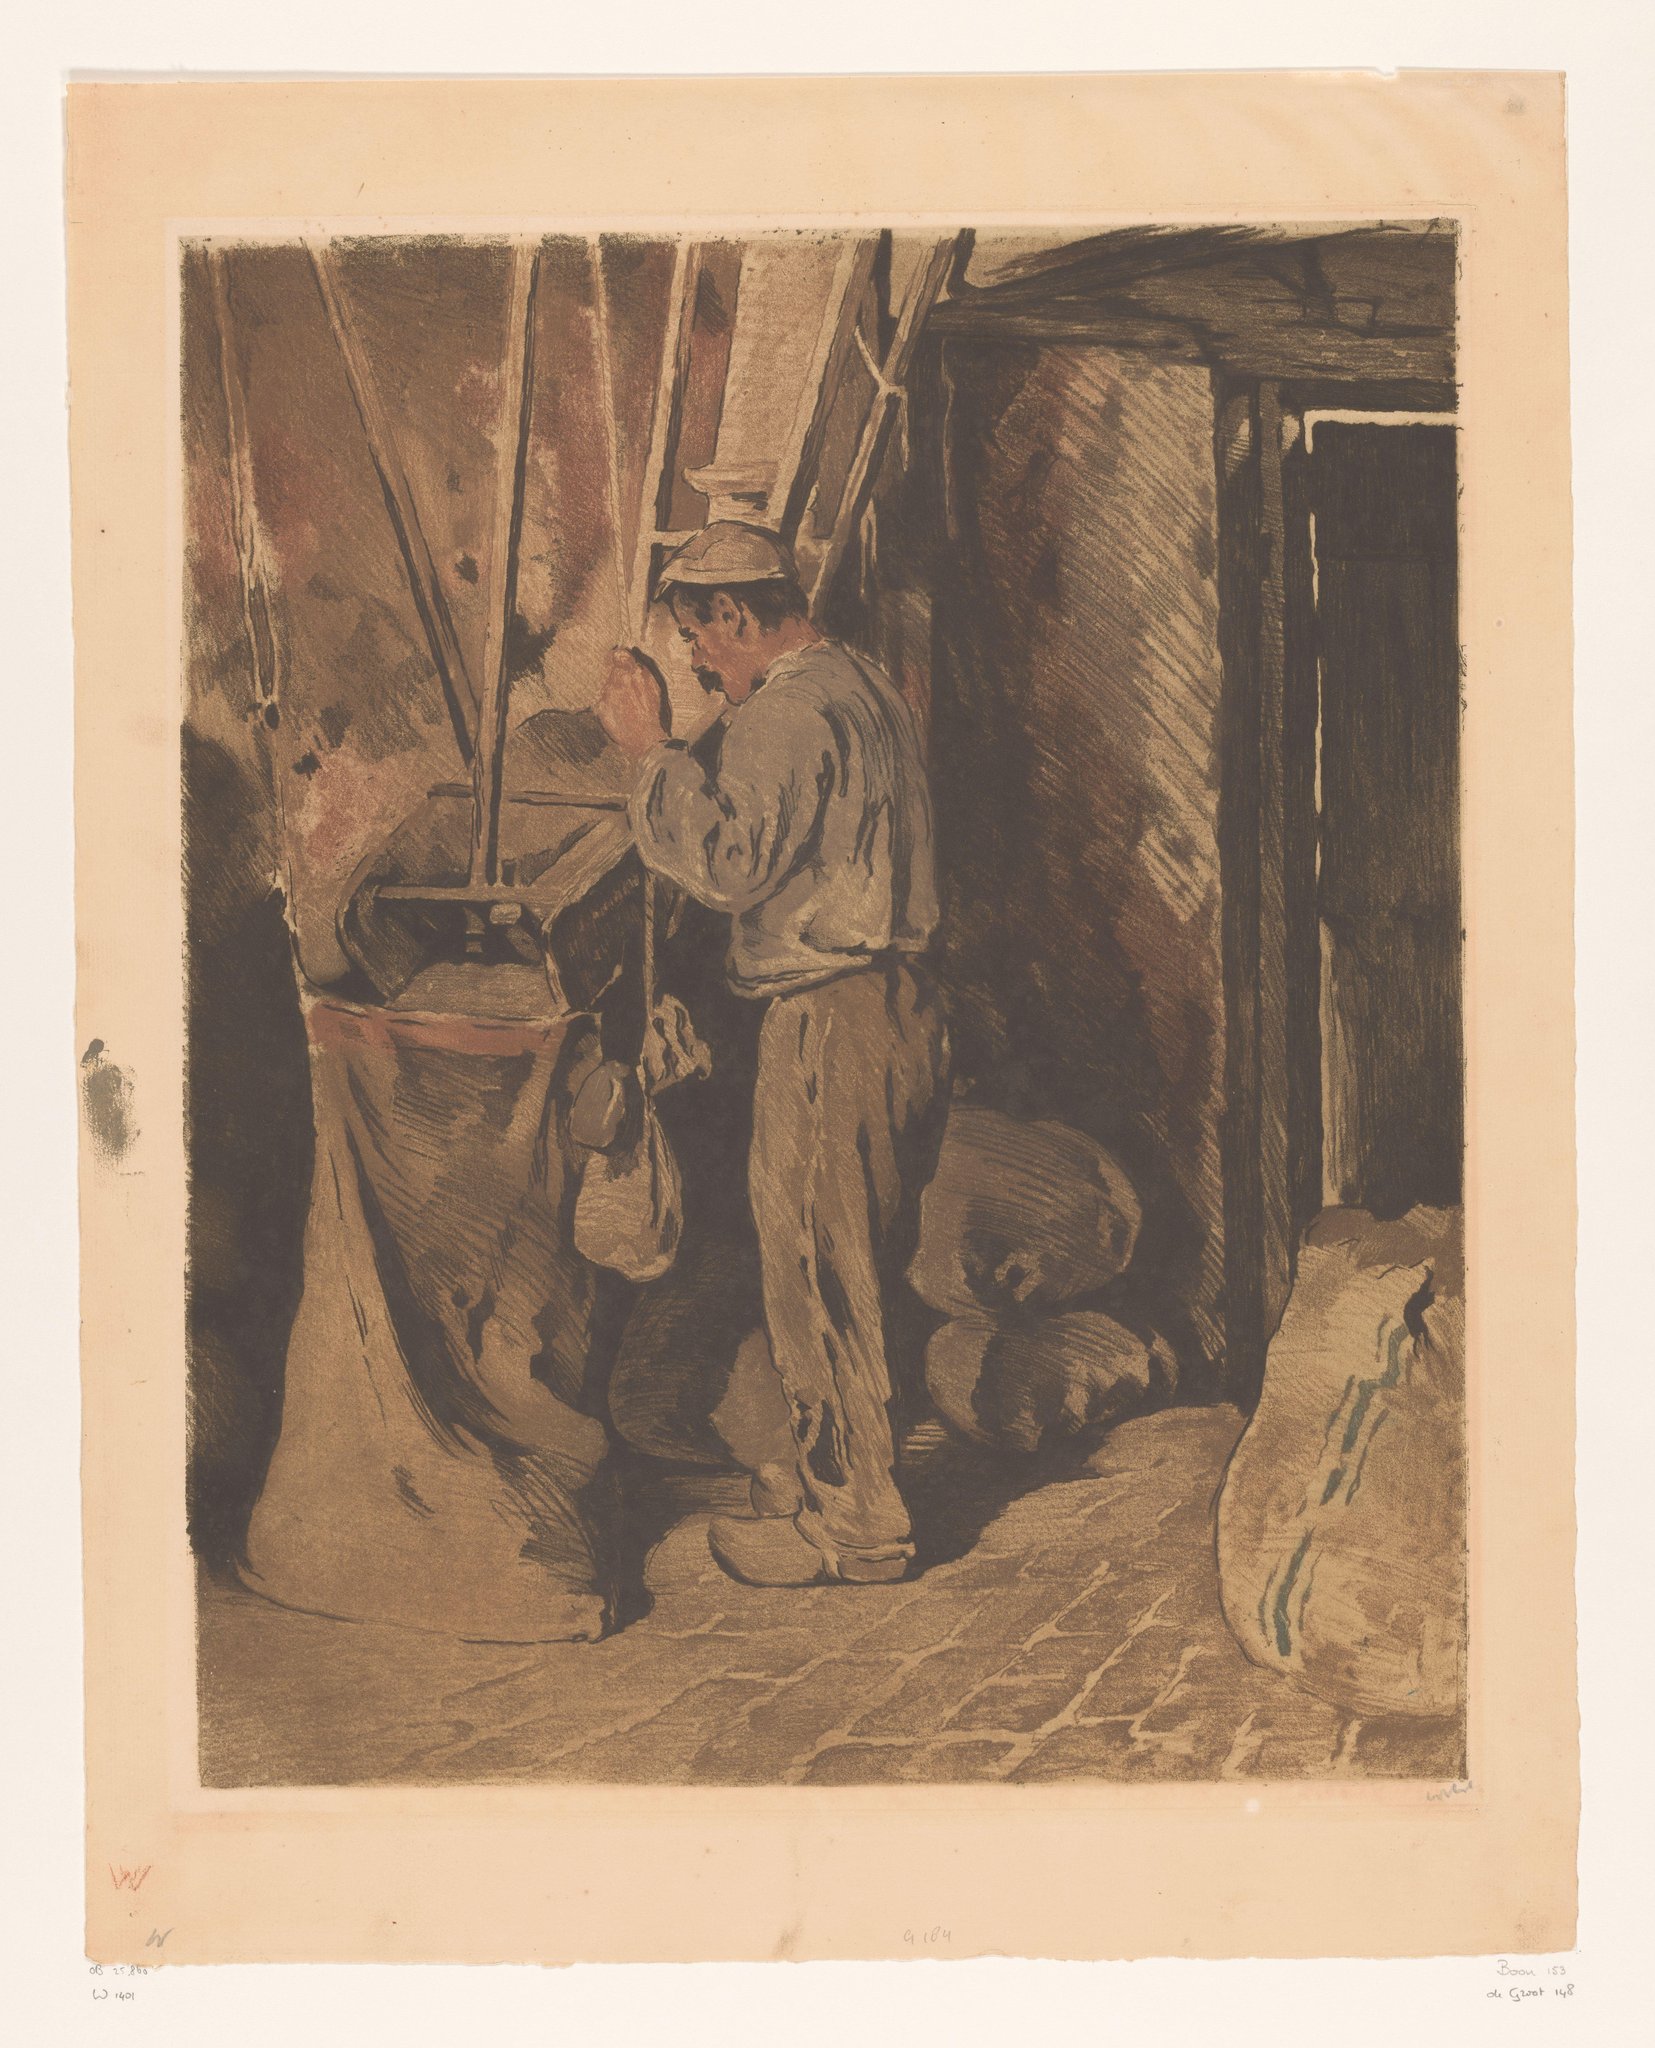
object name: print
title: Molenaar bij een zak meel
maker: willem witsen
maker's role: draughtsman, painter, print maker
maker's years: 1860-1923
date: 1910-1911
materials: paper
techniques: soft ground etching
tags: miller, windmill